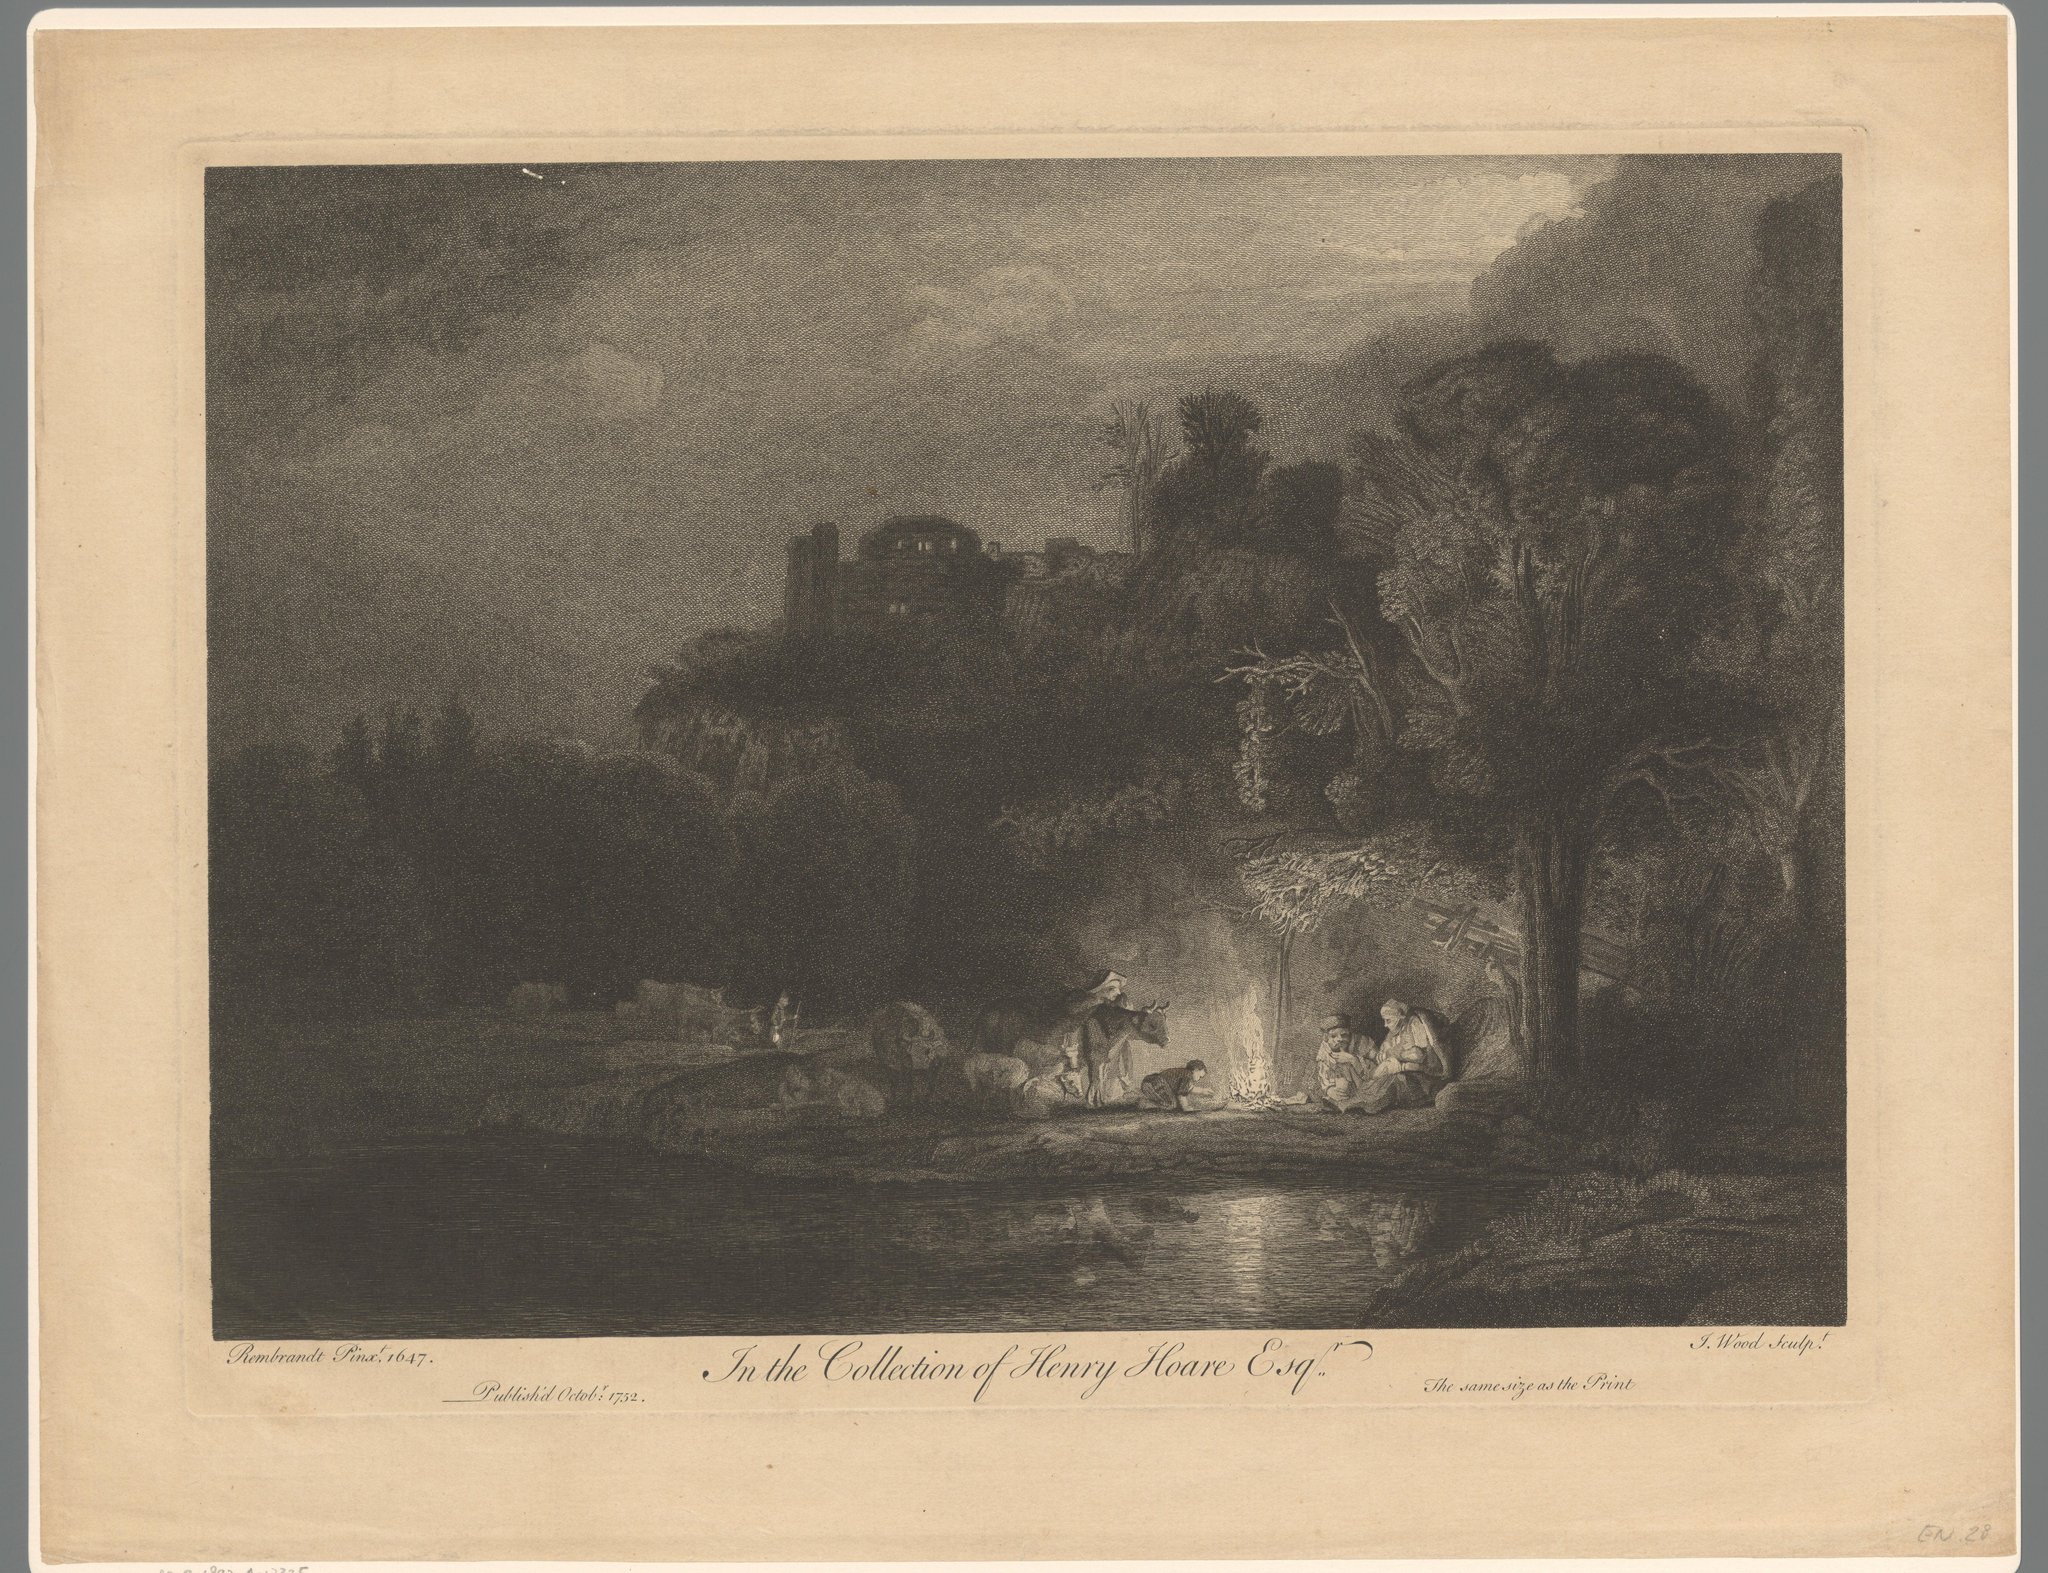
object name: print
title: Rust op de vlucht naar Egypte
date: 1752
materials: paper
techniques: etching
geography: london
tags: rest on the flight into egypt, night ~ landscape (sometimes titled 'nox')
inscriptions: collector's mark: Lugt 2228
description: Nachtelijk landschap. De heilige familie zit bij een vuur. Aan de oever een kudde ossen en drie andere figuren.